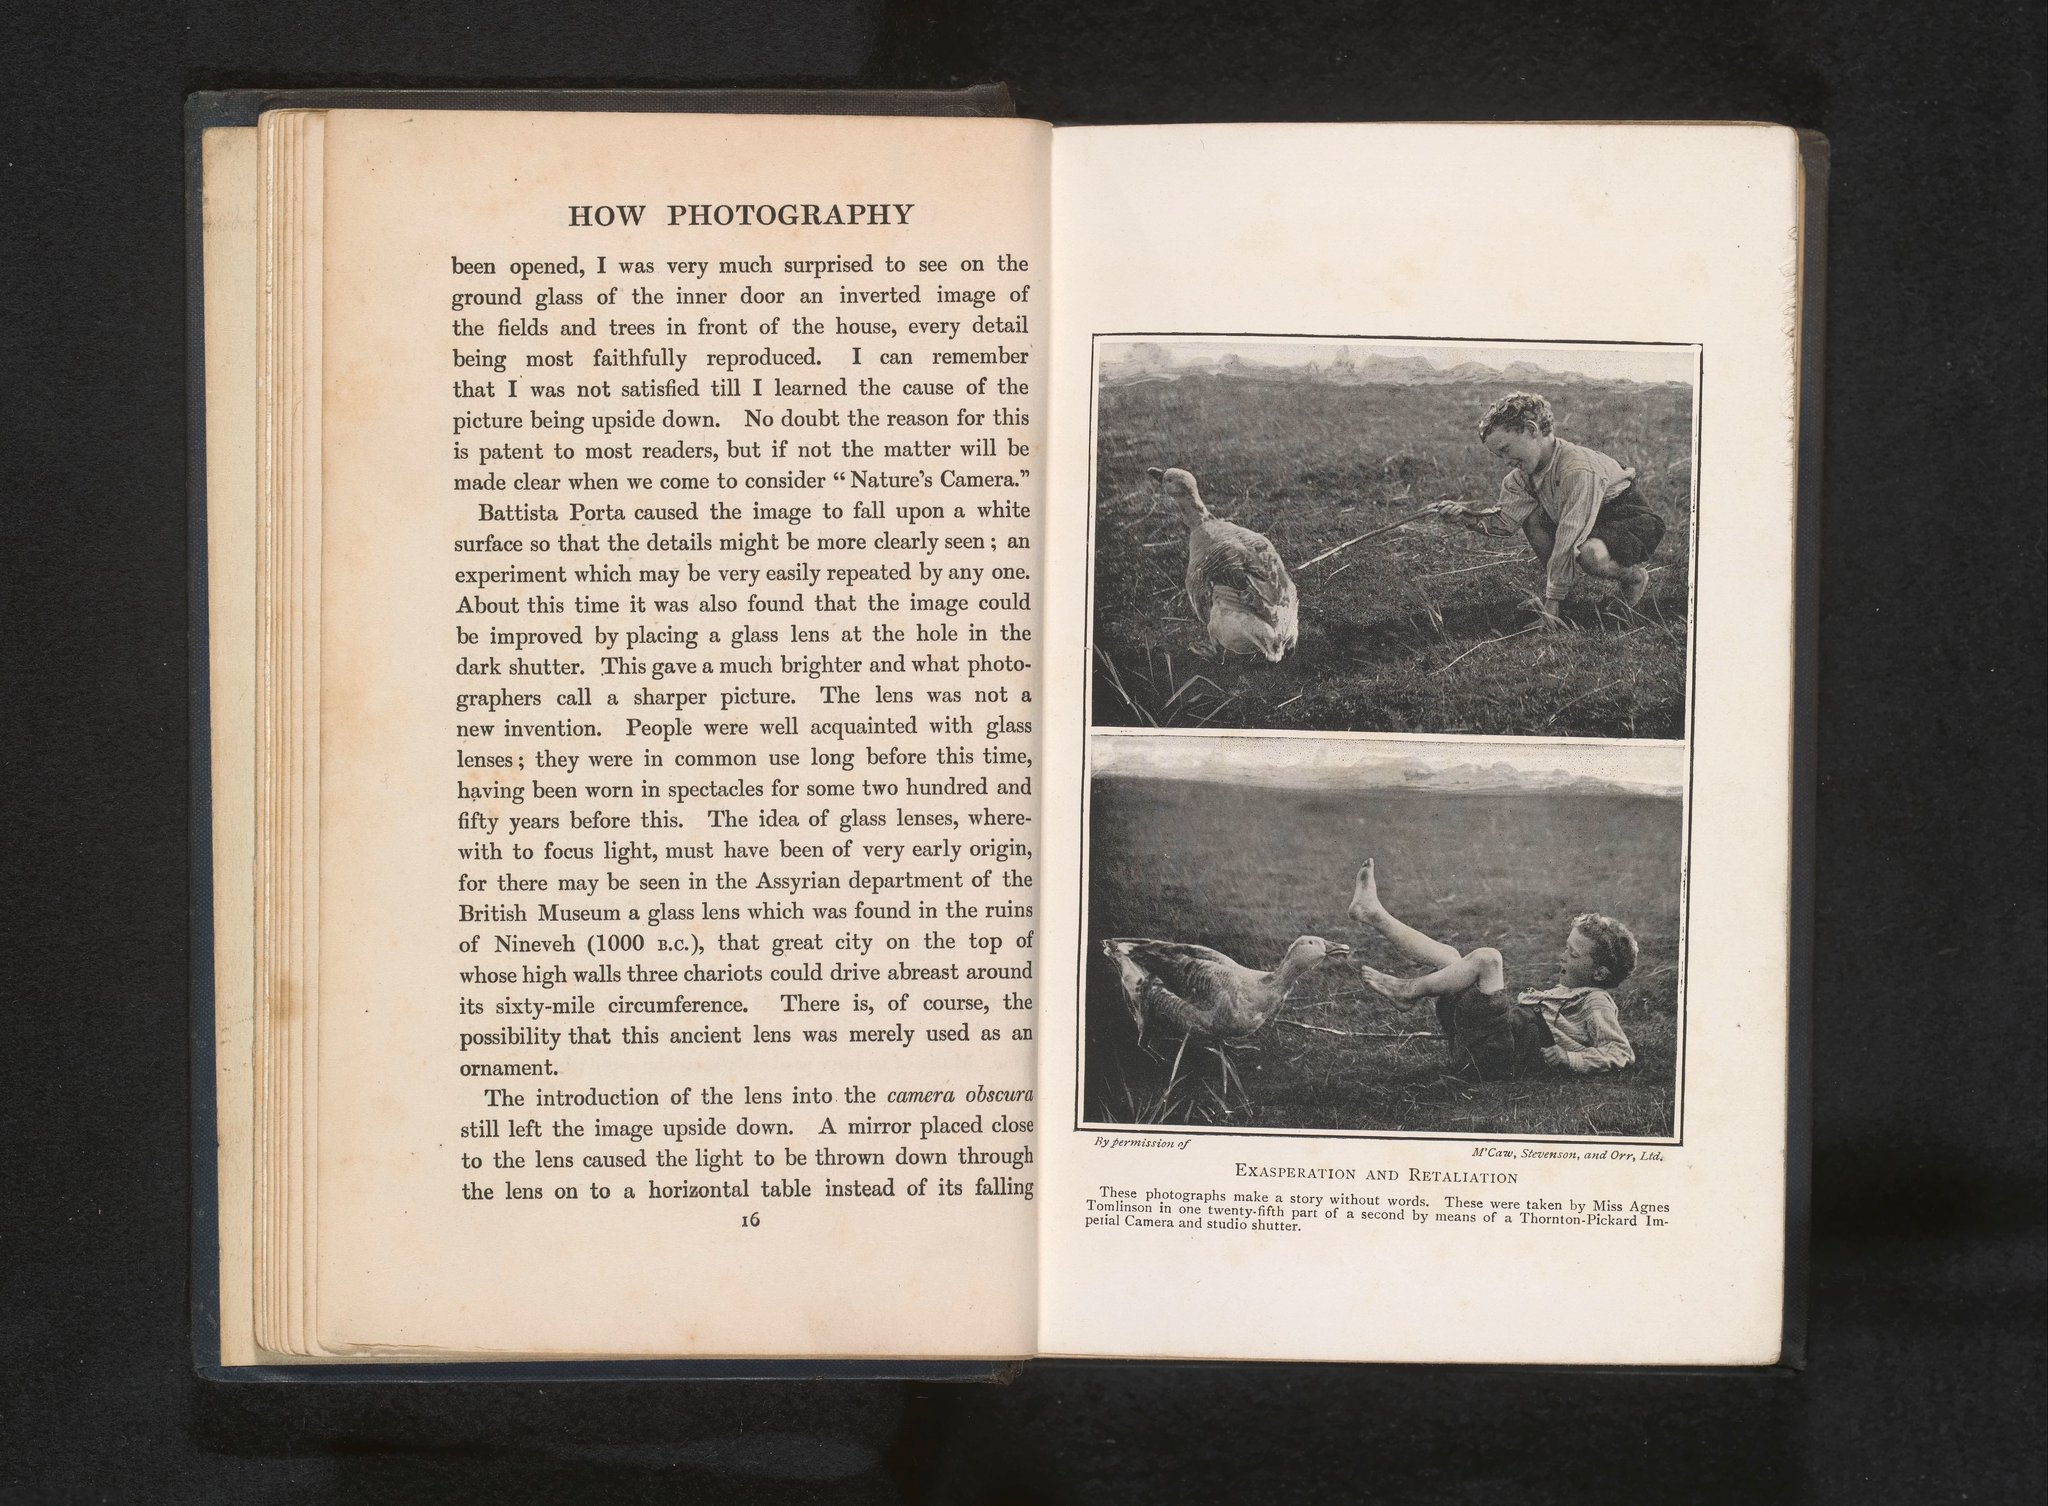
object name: photomechanical print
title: Tweemaal een jongen met een gans in een grasland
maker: agnes tomlinson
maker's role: fotograaf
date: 1898-1908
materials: paper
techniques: autotype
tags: water-birds: goose, boy (child between toddler and youth)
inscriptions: inscription: ‘These photographs make a story without words. These were taken by Miss Agnes Tomlinson in one twenty-fifth part of a second by means of a Thornton-Pickard Imperial Camera and studio shutter.’